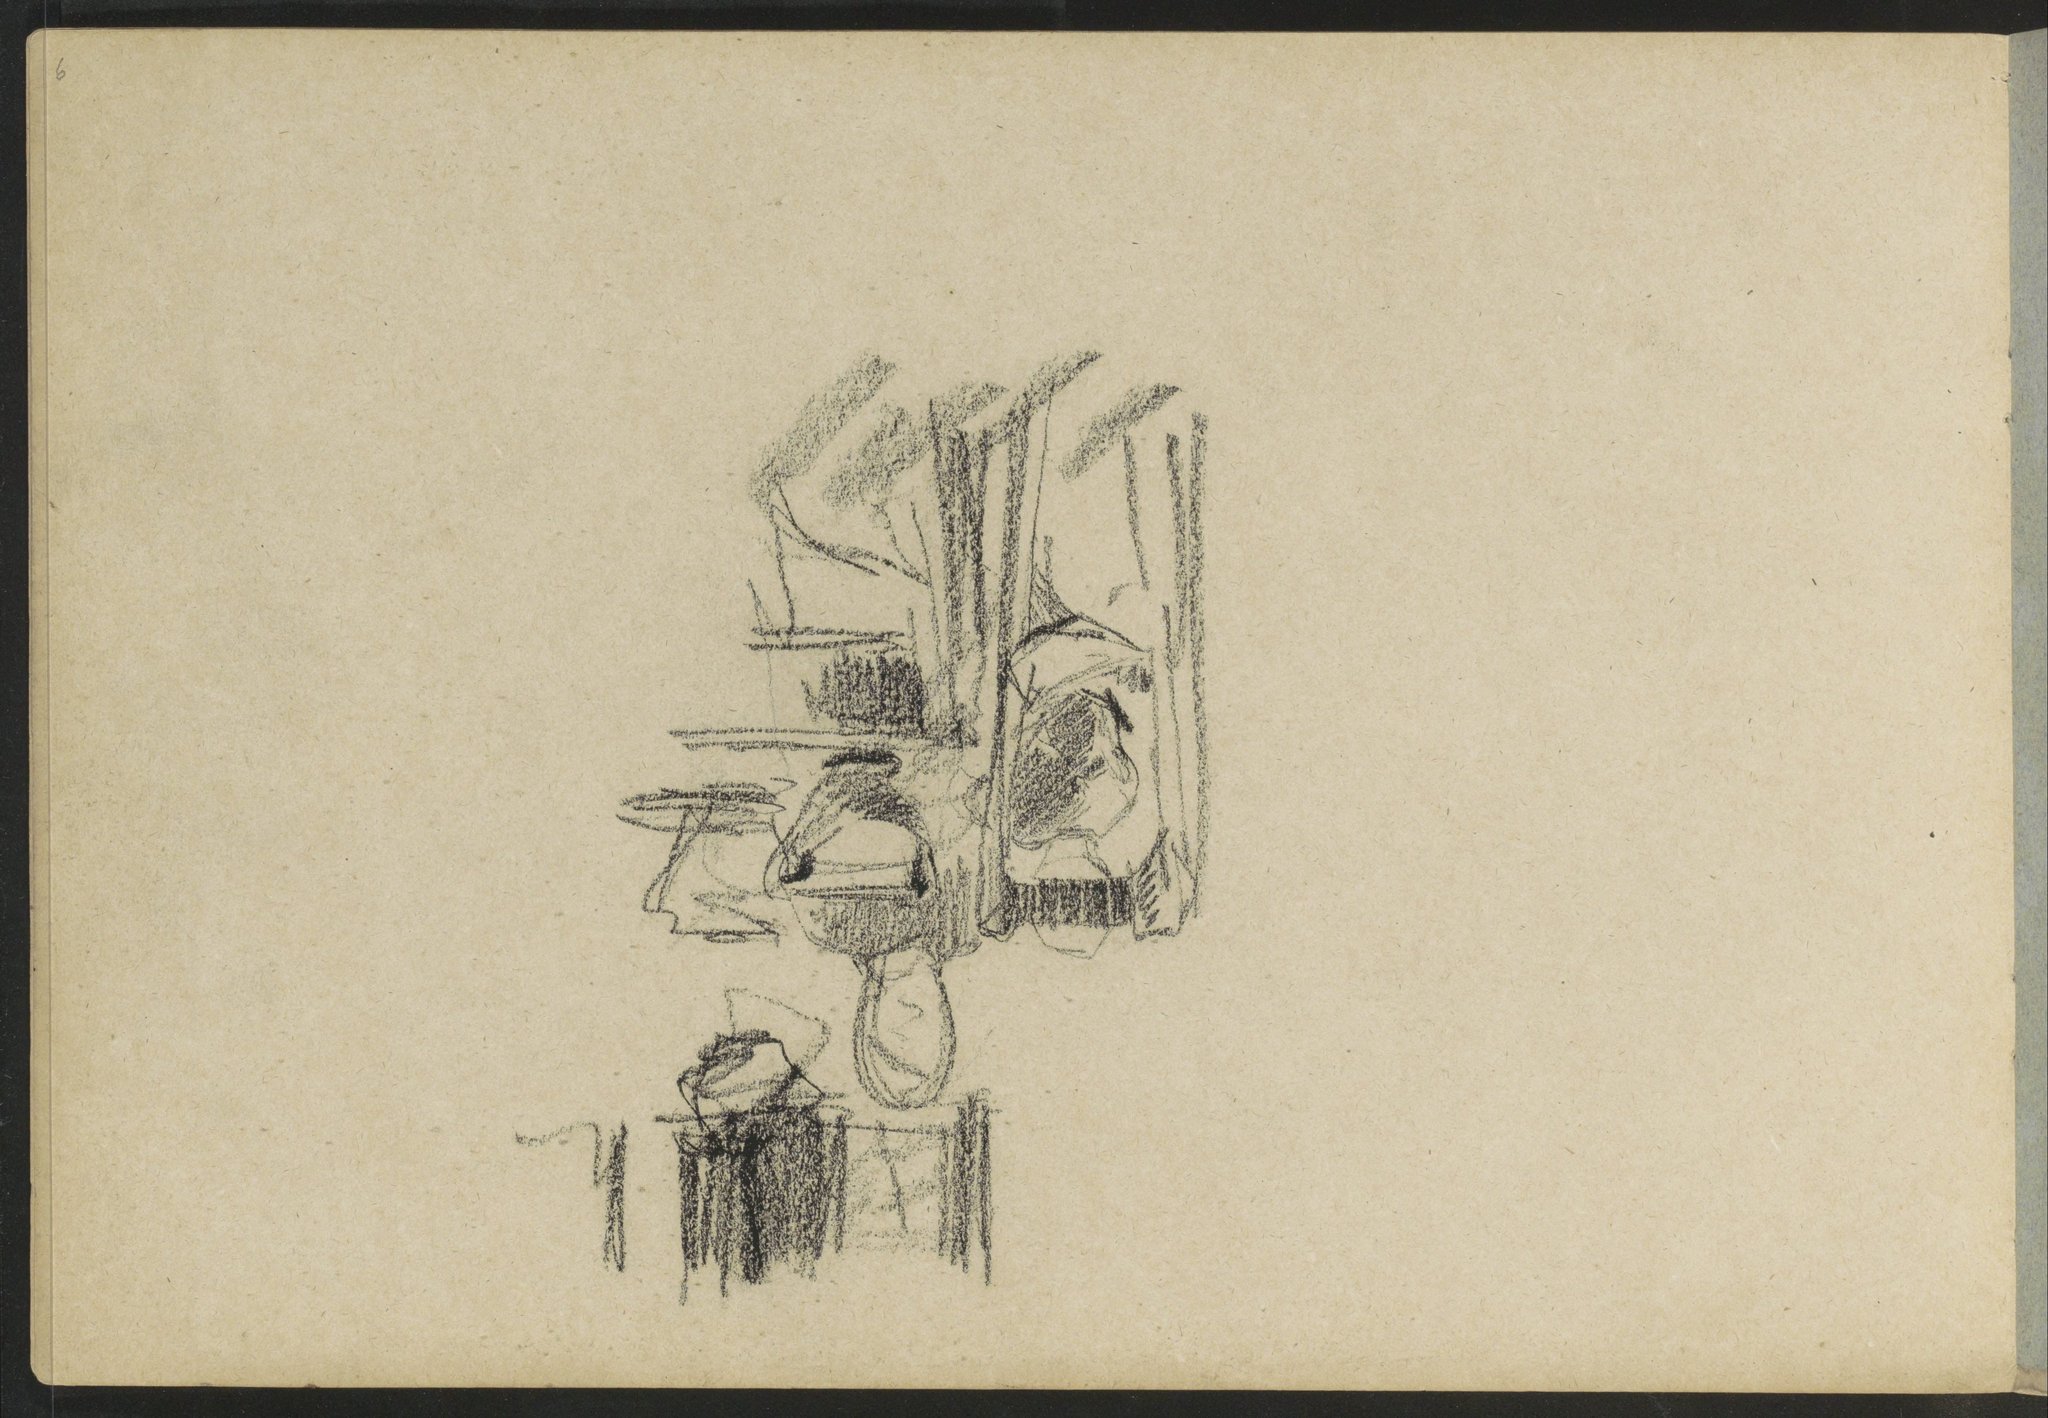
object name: sketchbook leaf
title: Vrouw en kind aan tafel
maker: willem witsen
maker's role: draughtsman, painter, print maker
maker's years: 1860-1923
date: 1884-1887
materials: chalk, paper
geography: ewijkshoeve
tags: interior of the house, adult woman (+ sitting), child (+ sitting)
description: Pagina 6 uit een schetsboek met 29 bladen.